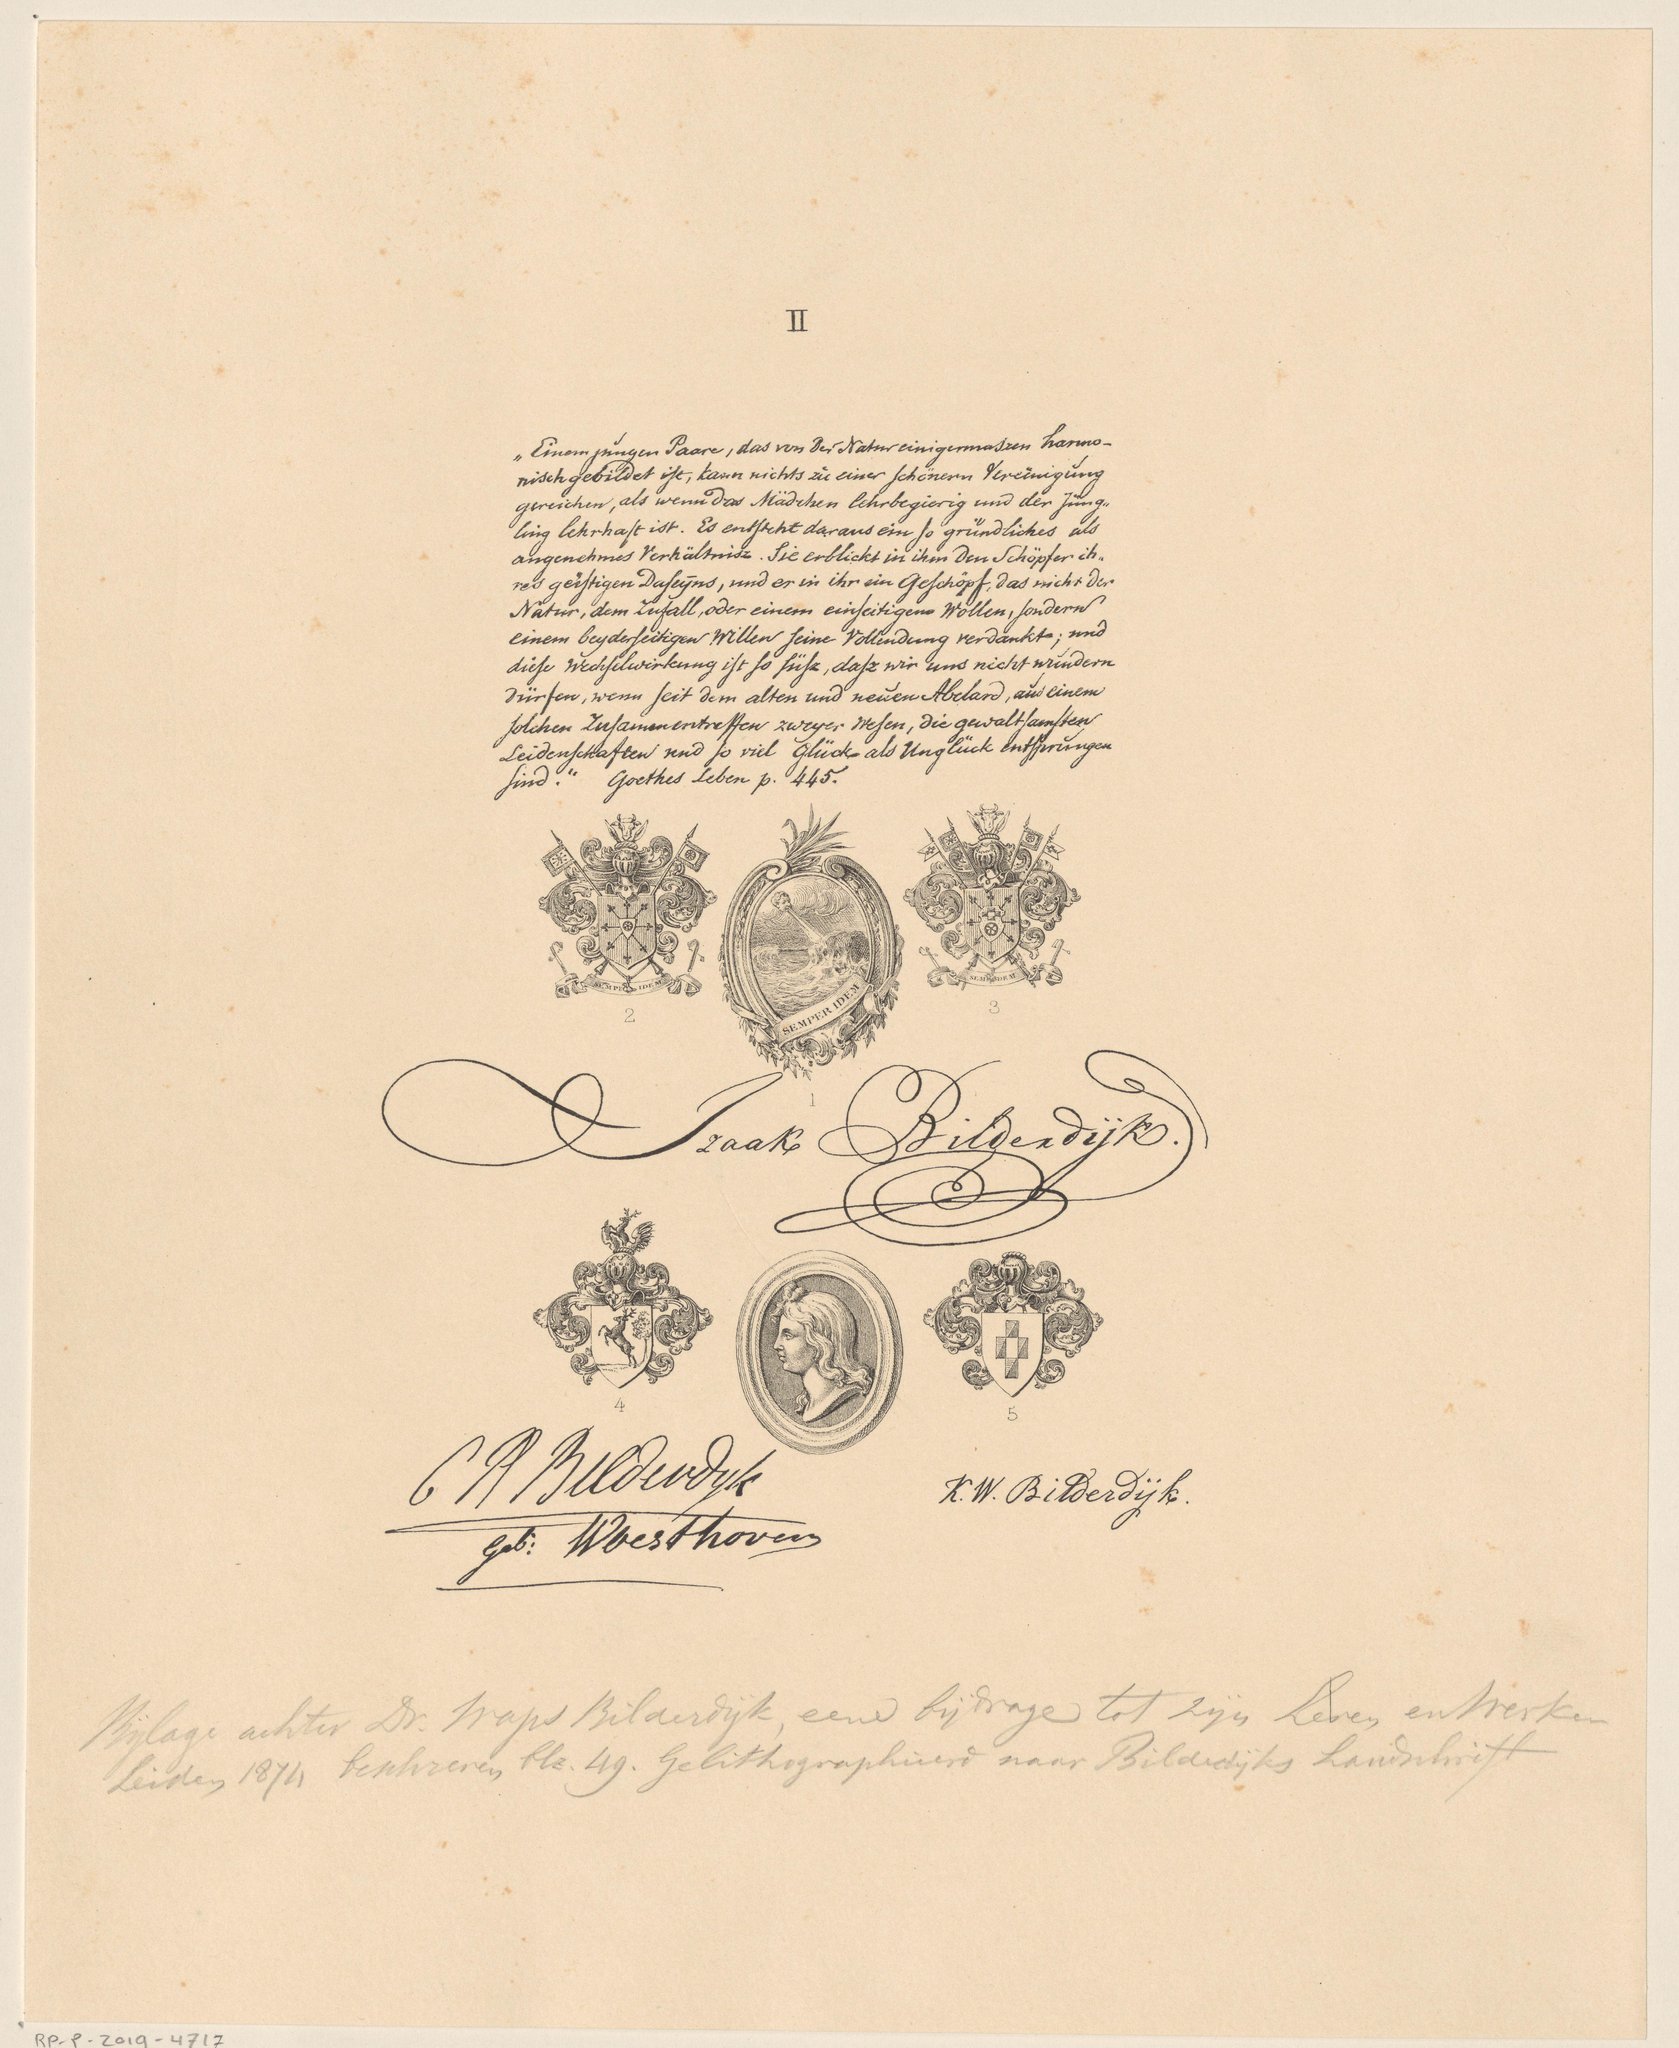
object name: print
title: Wapenschilden en handtekeningen van de familie Bilderdijk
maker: Anonymous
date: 1874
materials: paper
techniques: lithograph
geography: leiden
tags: armorial bearing, heraldry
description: Prent uit: Wap, Jan. J.F. Bilderdijk: eene bijdrage tot zijn leven en werken. Leiden: E.J. Brill, 1874.